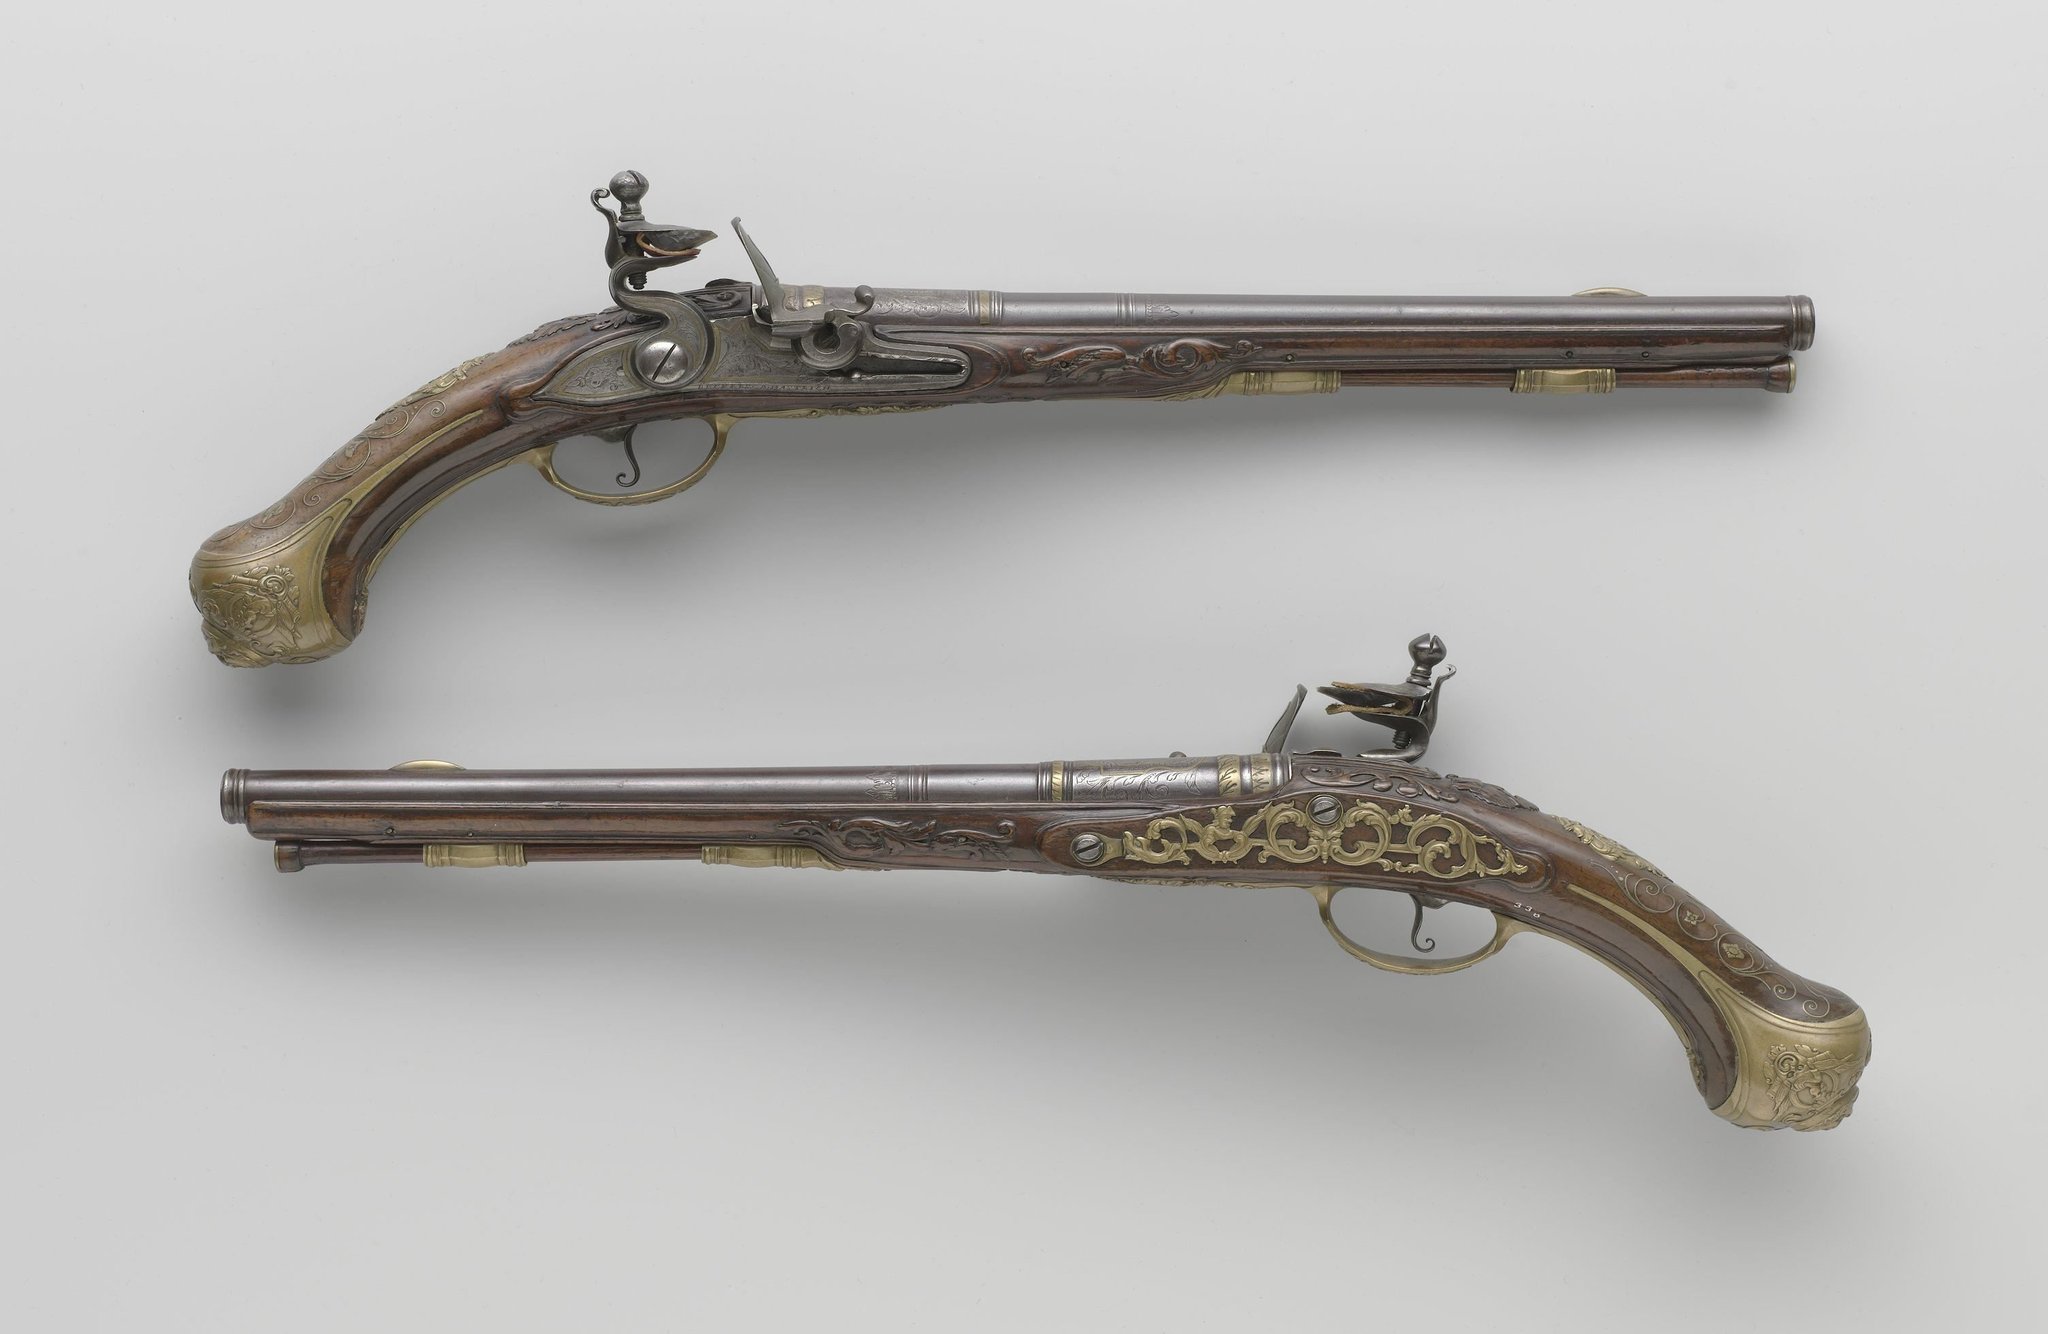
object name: flintlock pistol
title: Vuursteenpistool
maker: mattis beckers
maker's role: geweermaker, pistoolmaker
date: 1720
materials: brass, iron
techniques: printing, casting, metalworking, cutting, embroidery, engraving, gilding, inlay, relief, striking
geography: maastricht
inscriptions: mark: ‘T’, signature: ‘BECKERS'A'MASTRICH’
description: Tentoongesteld in: Stedelijk Museum De Lakenhal, Leiden, juli-sept 1978.